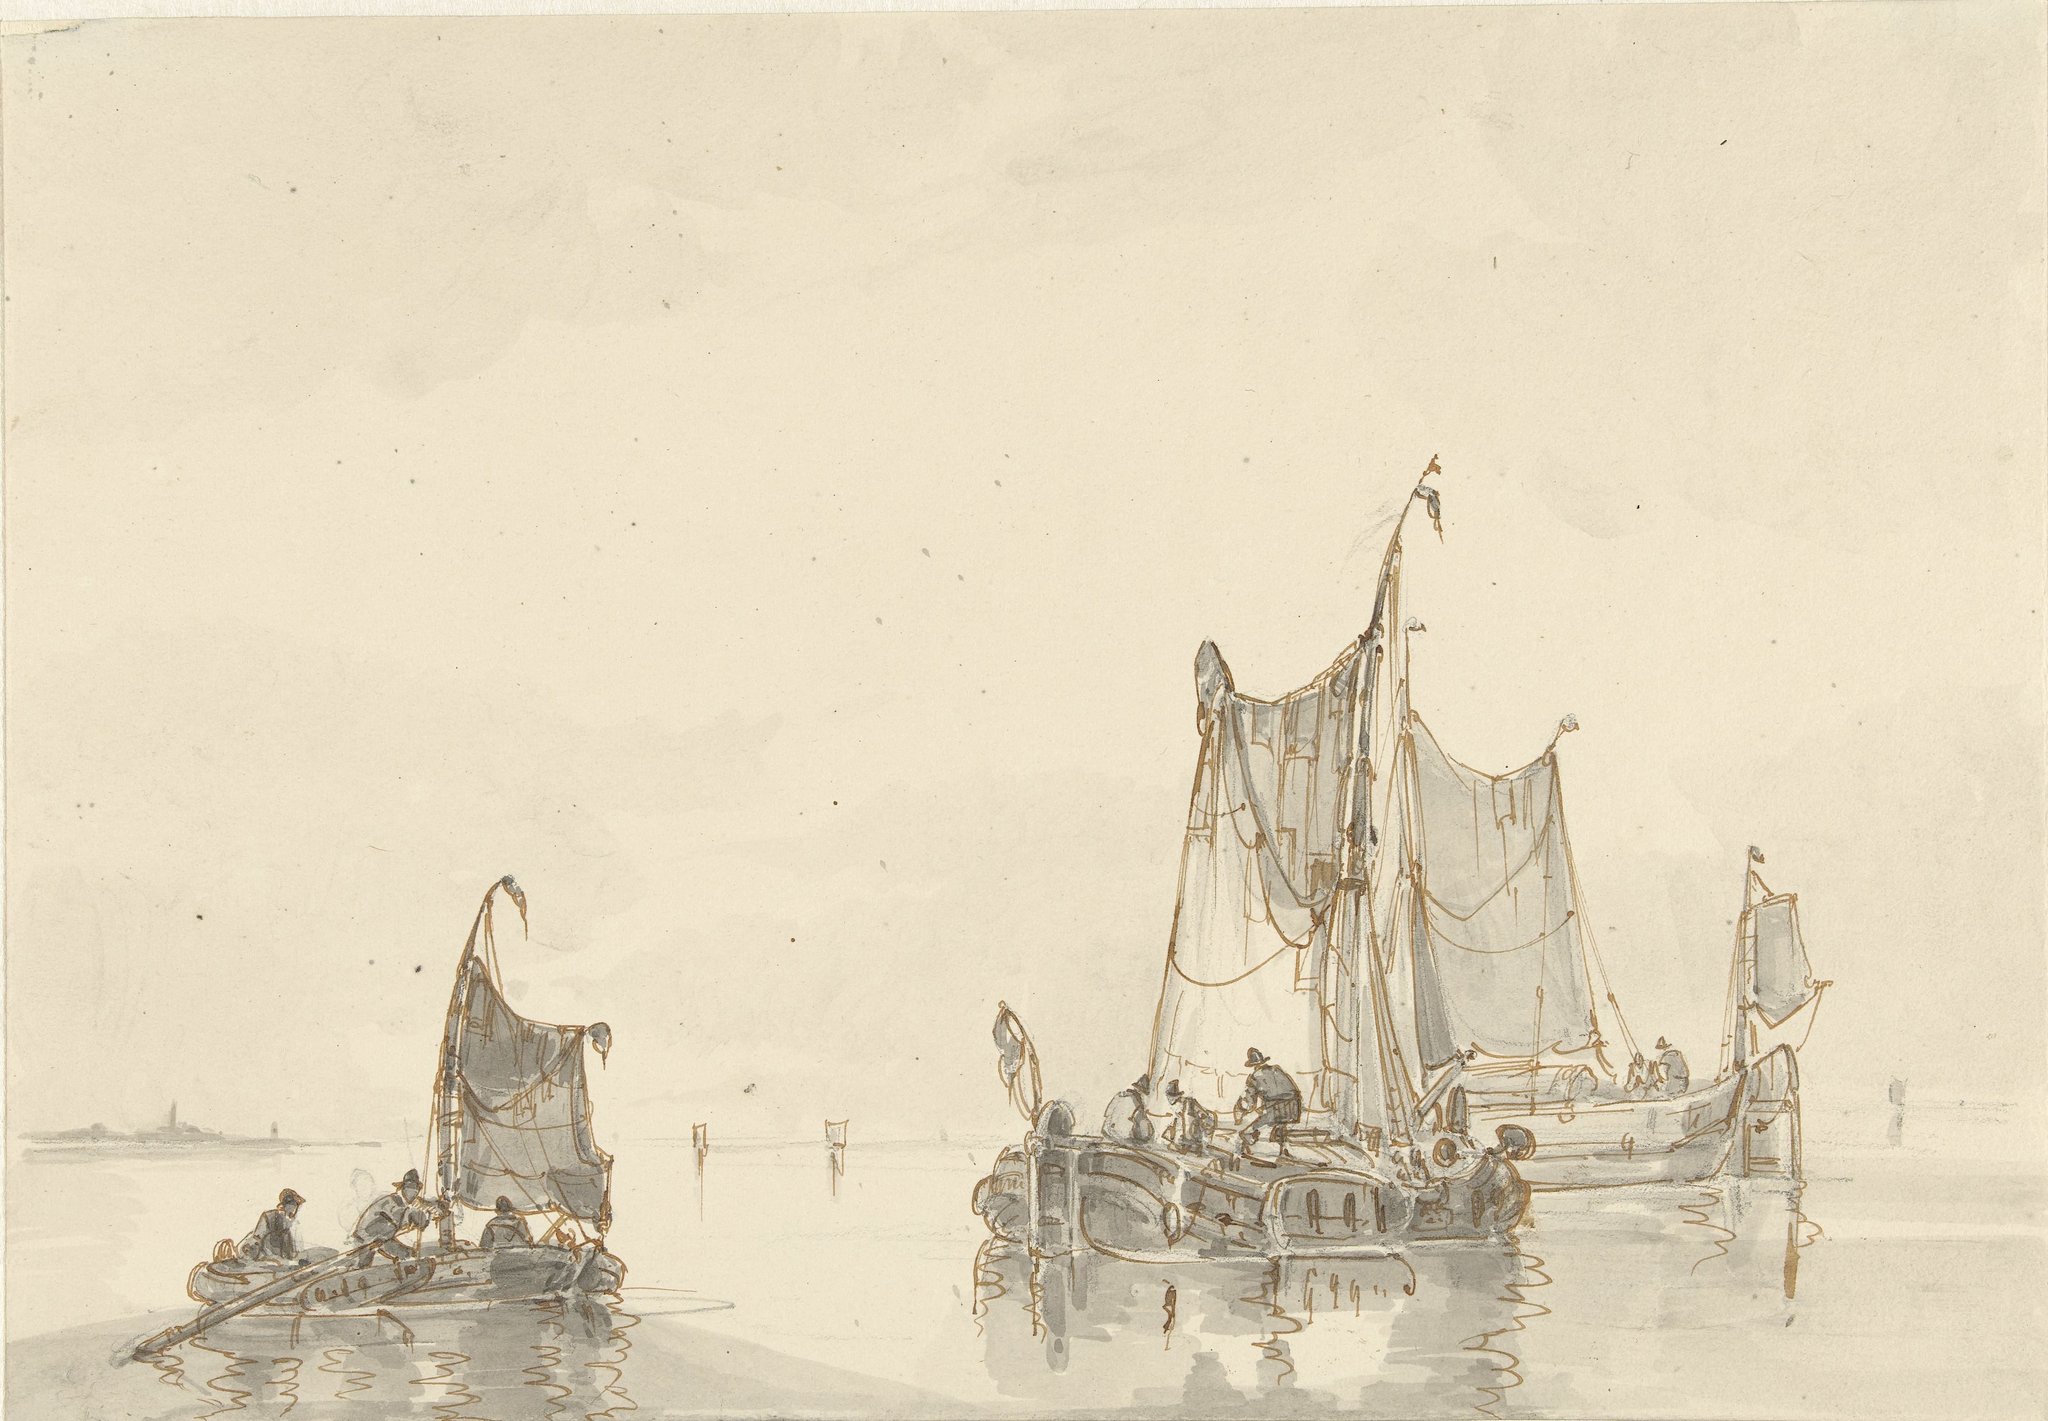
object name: drawing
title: Drie zeilschepen op het water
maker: albertus van beest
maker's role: draughtsman, print maker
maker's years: 1820-1860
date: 1830-1860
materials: ink, paper, pencil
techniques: brush, pen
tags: sailing-ship, sailing-boat